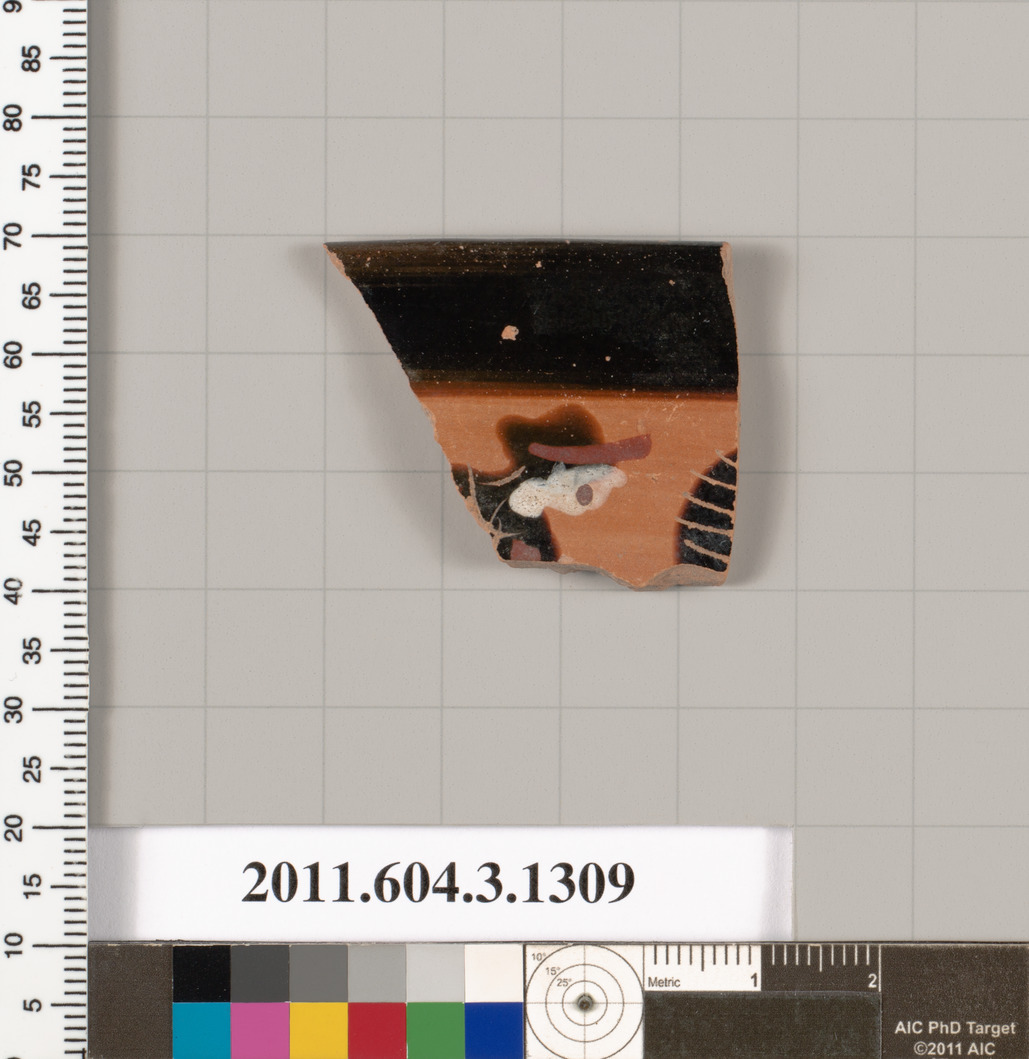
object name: skyphos fragment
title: Terracotta rim fragment of a skyphos (deep drinking cup)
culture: greek, attic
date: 500-468 BCE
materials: terracotta